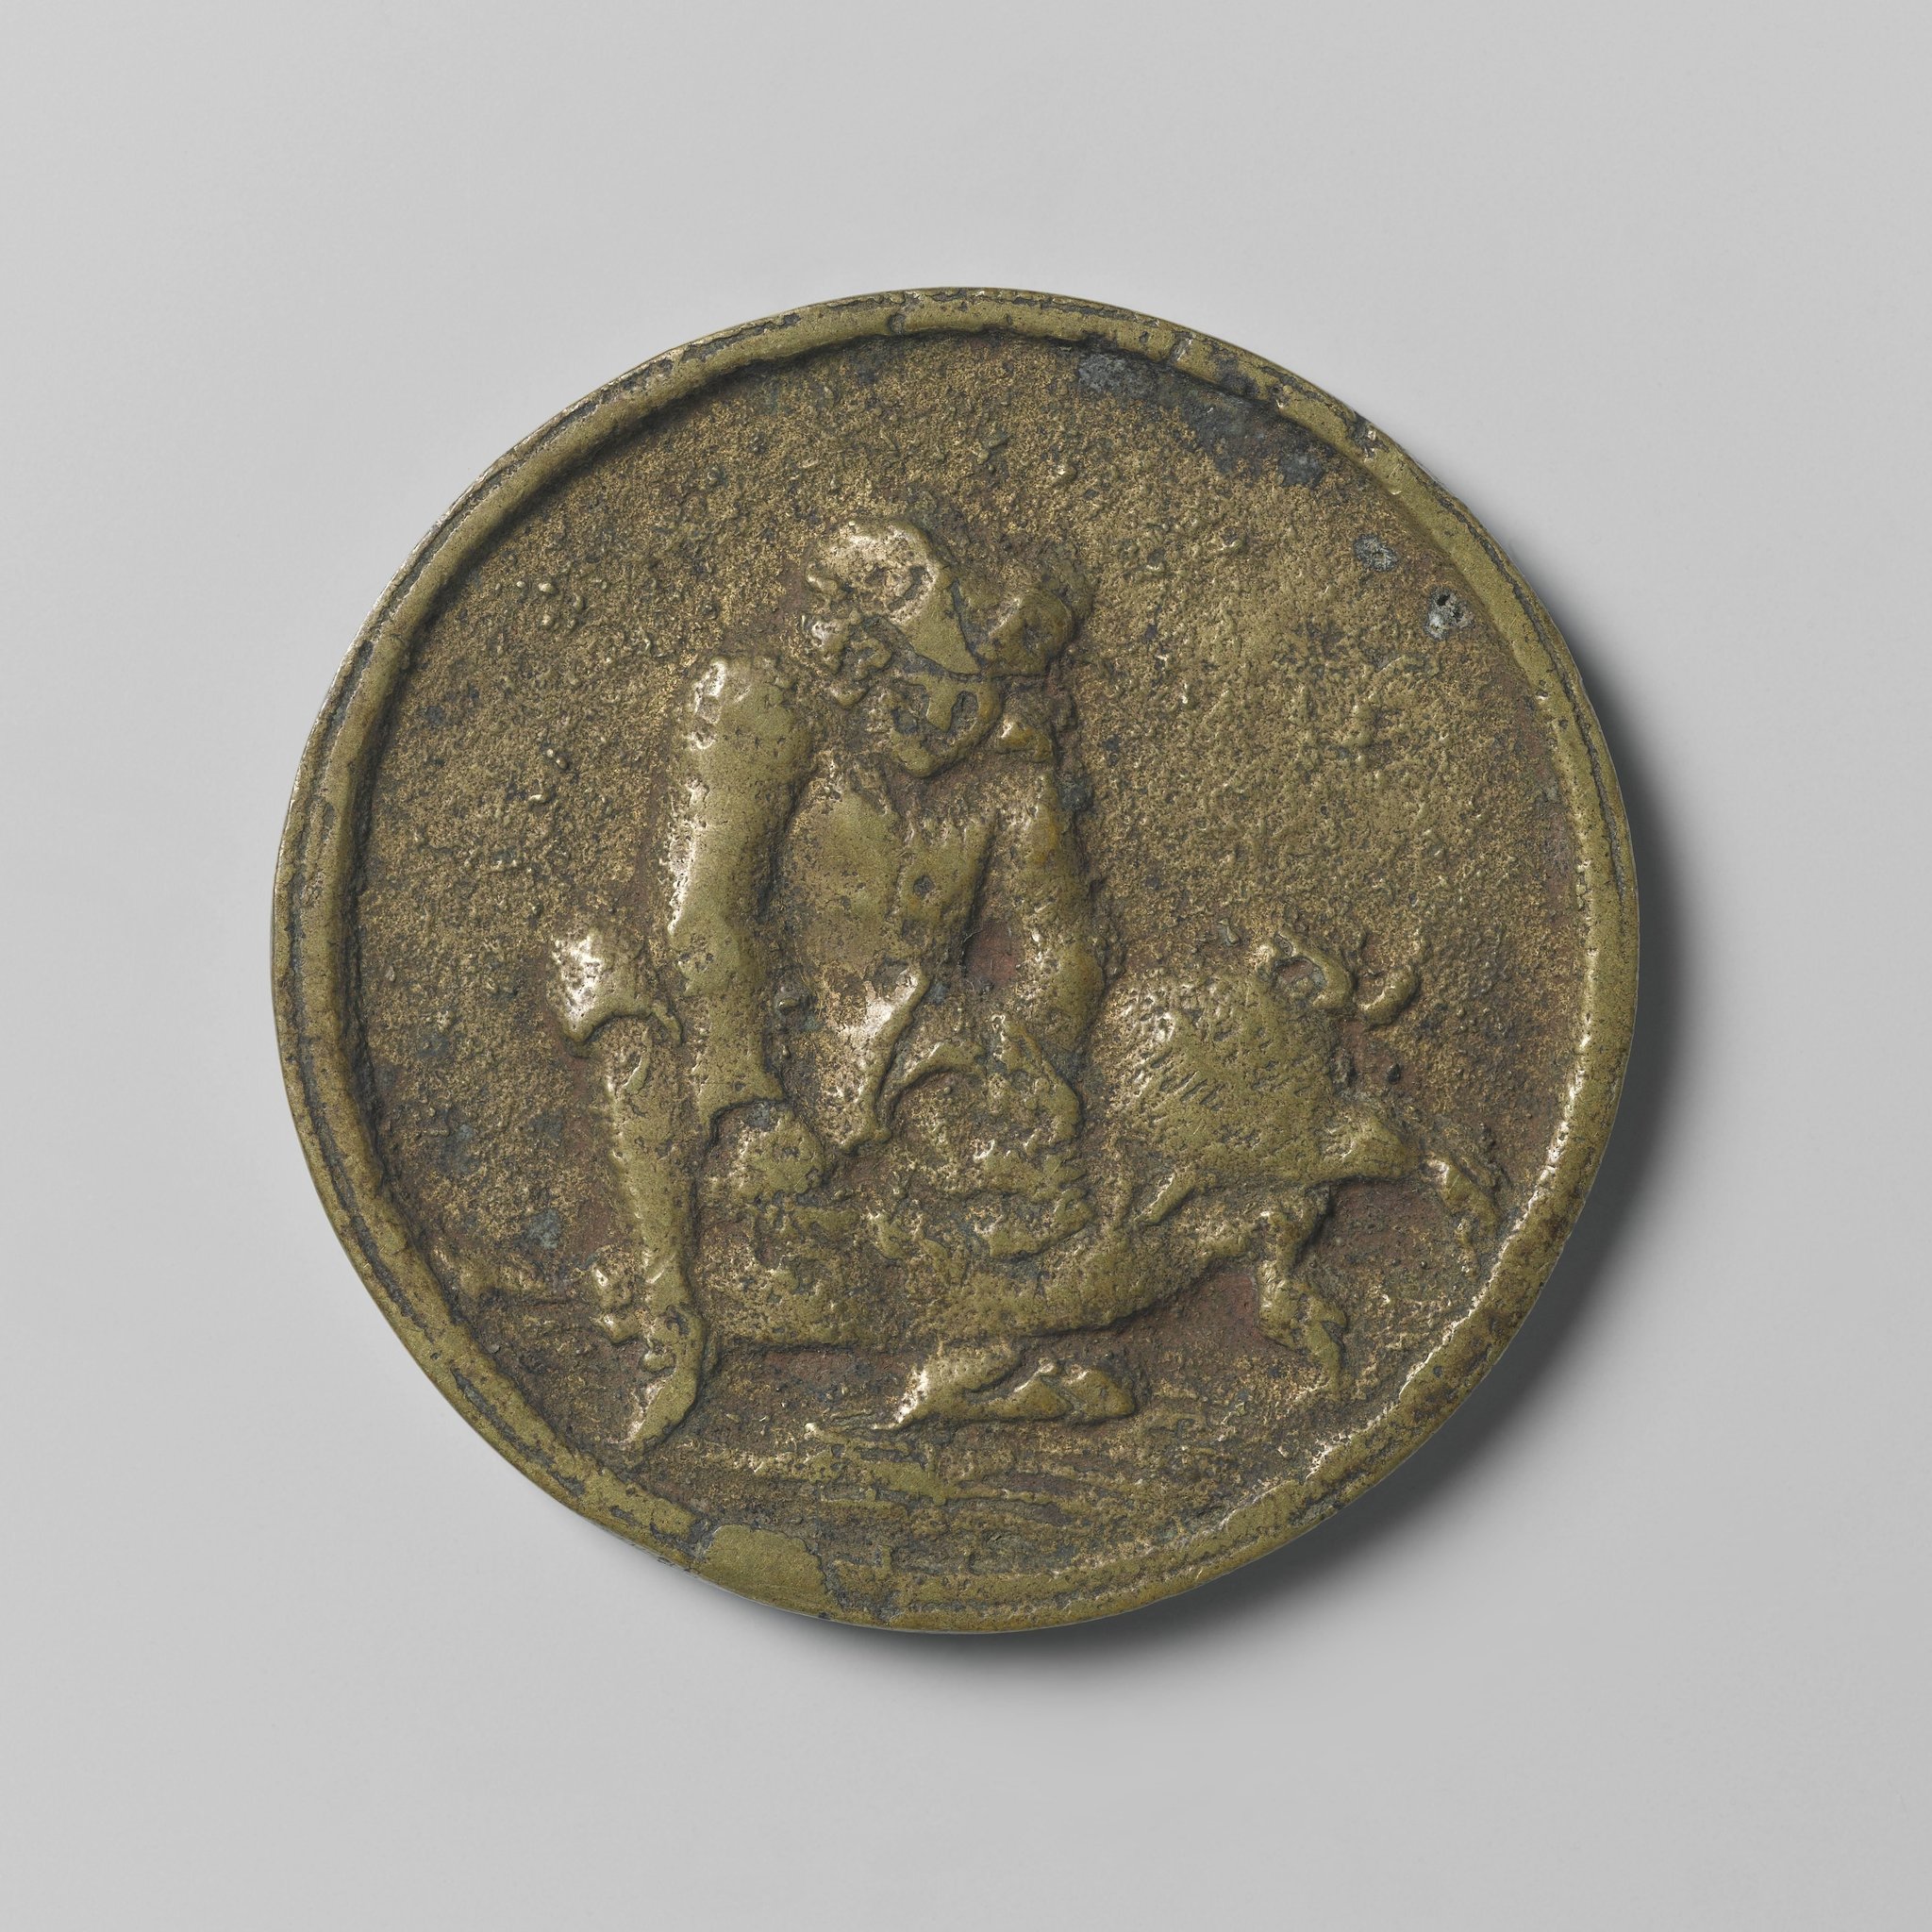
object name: plaque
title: Spek- en varkensslagersgilde van Amsterdam, gildepenning van Paulus Habel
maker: lucas cloppenburg (medailleur)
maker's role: medailleur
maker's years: 1707-1751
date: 1779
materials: brass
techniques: casting, engraving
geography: amsterdam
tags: amsterdam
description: Messing plaquette. Voorzijde: gekroond wapenschild, geflankeerd door twee leeuwen; afsnede: opschrift naast bloem. Keerzijde: man met driehoekige hoed op hoofd bezig ter aarde liggend varken te slachten.